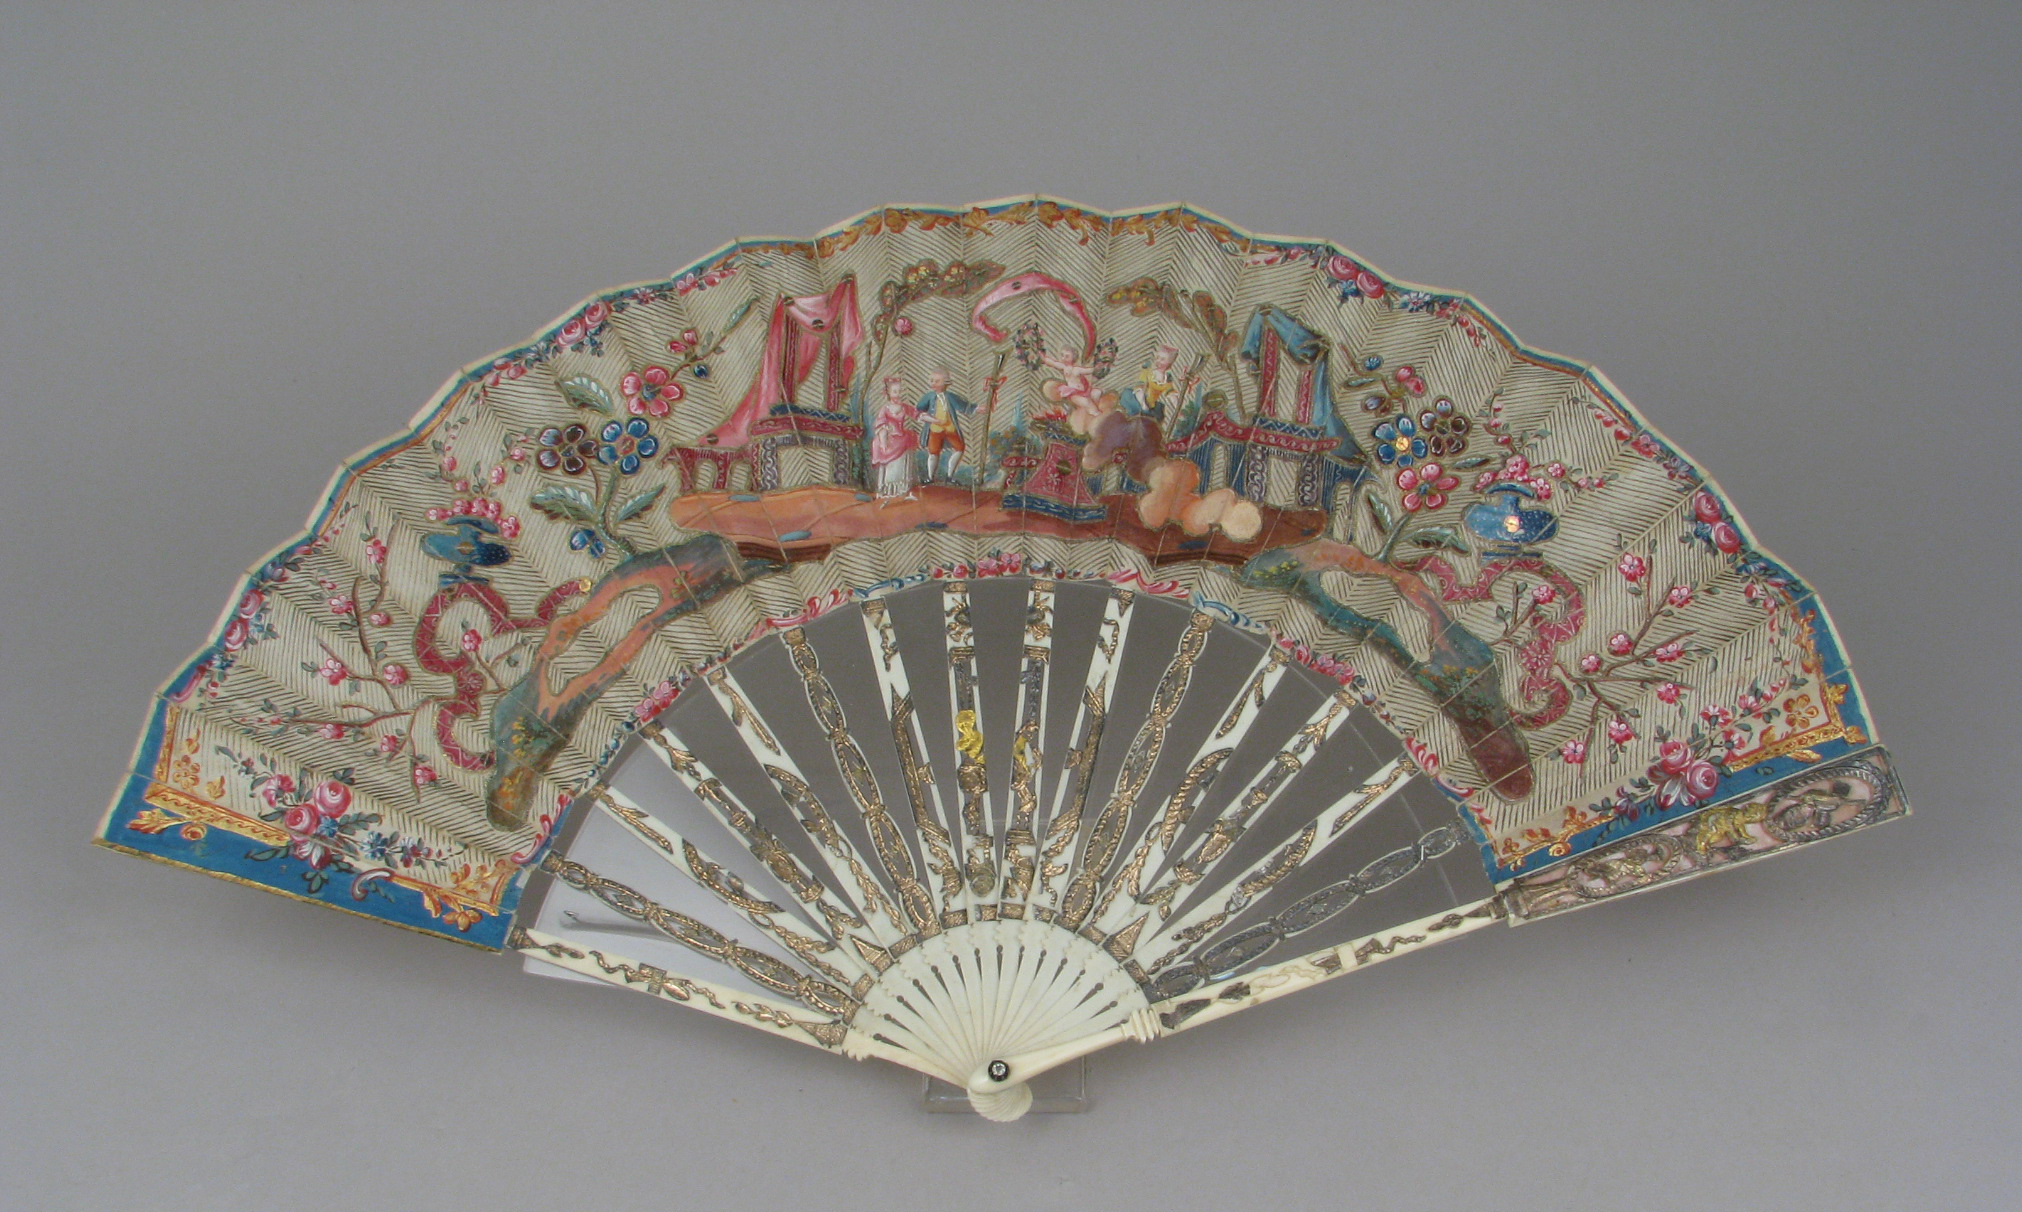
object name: fan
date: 1701-1800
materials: foil, glass, gold, ivory, metal thread, silk, silver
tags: men,women,flowers